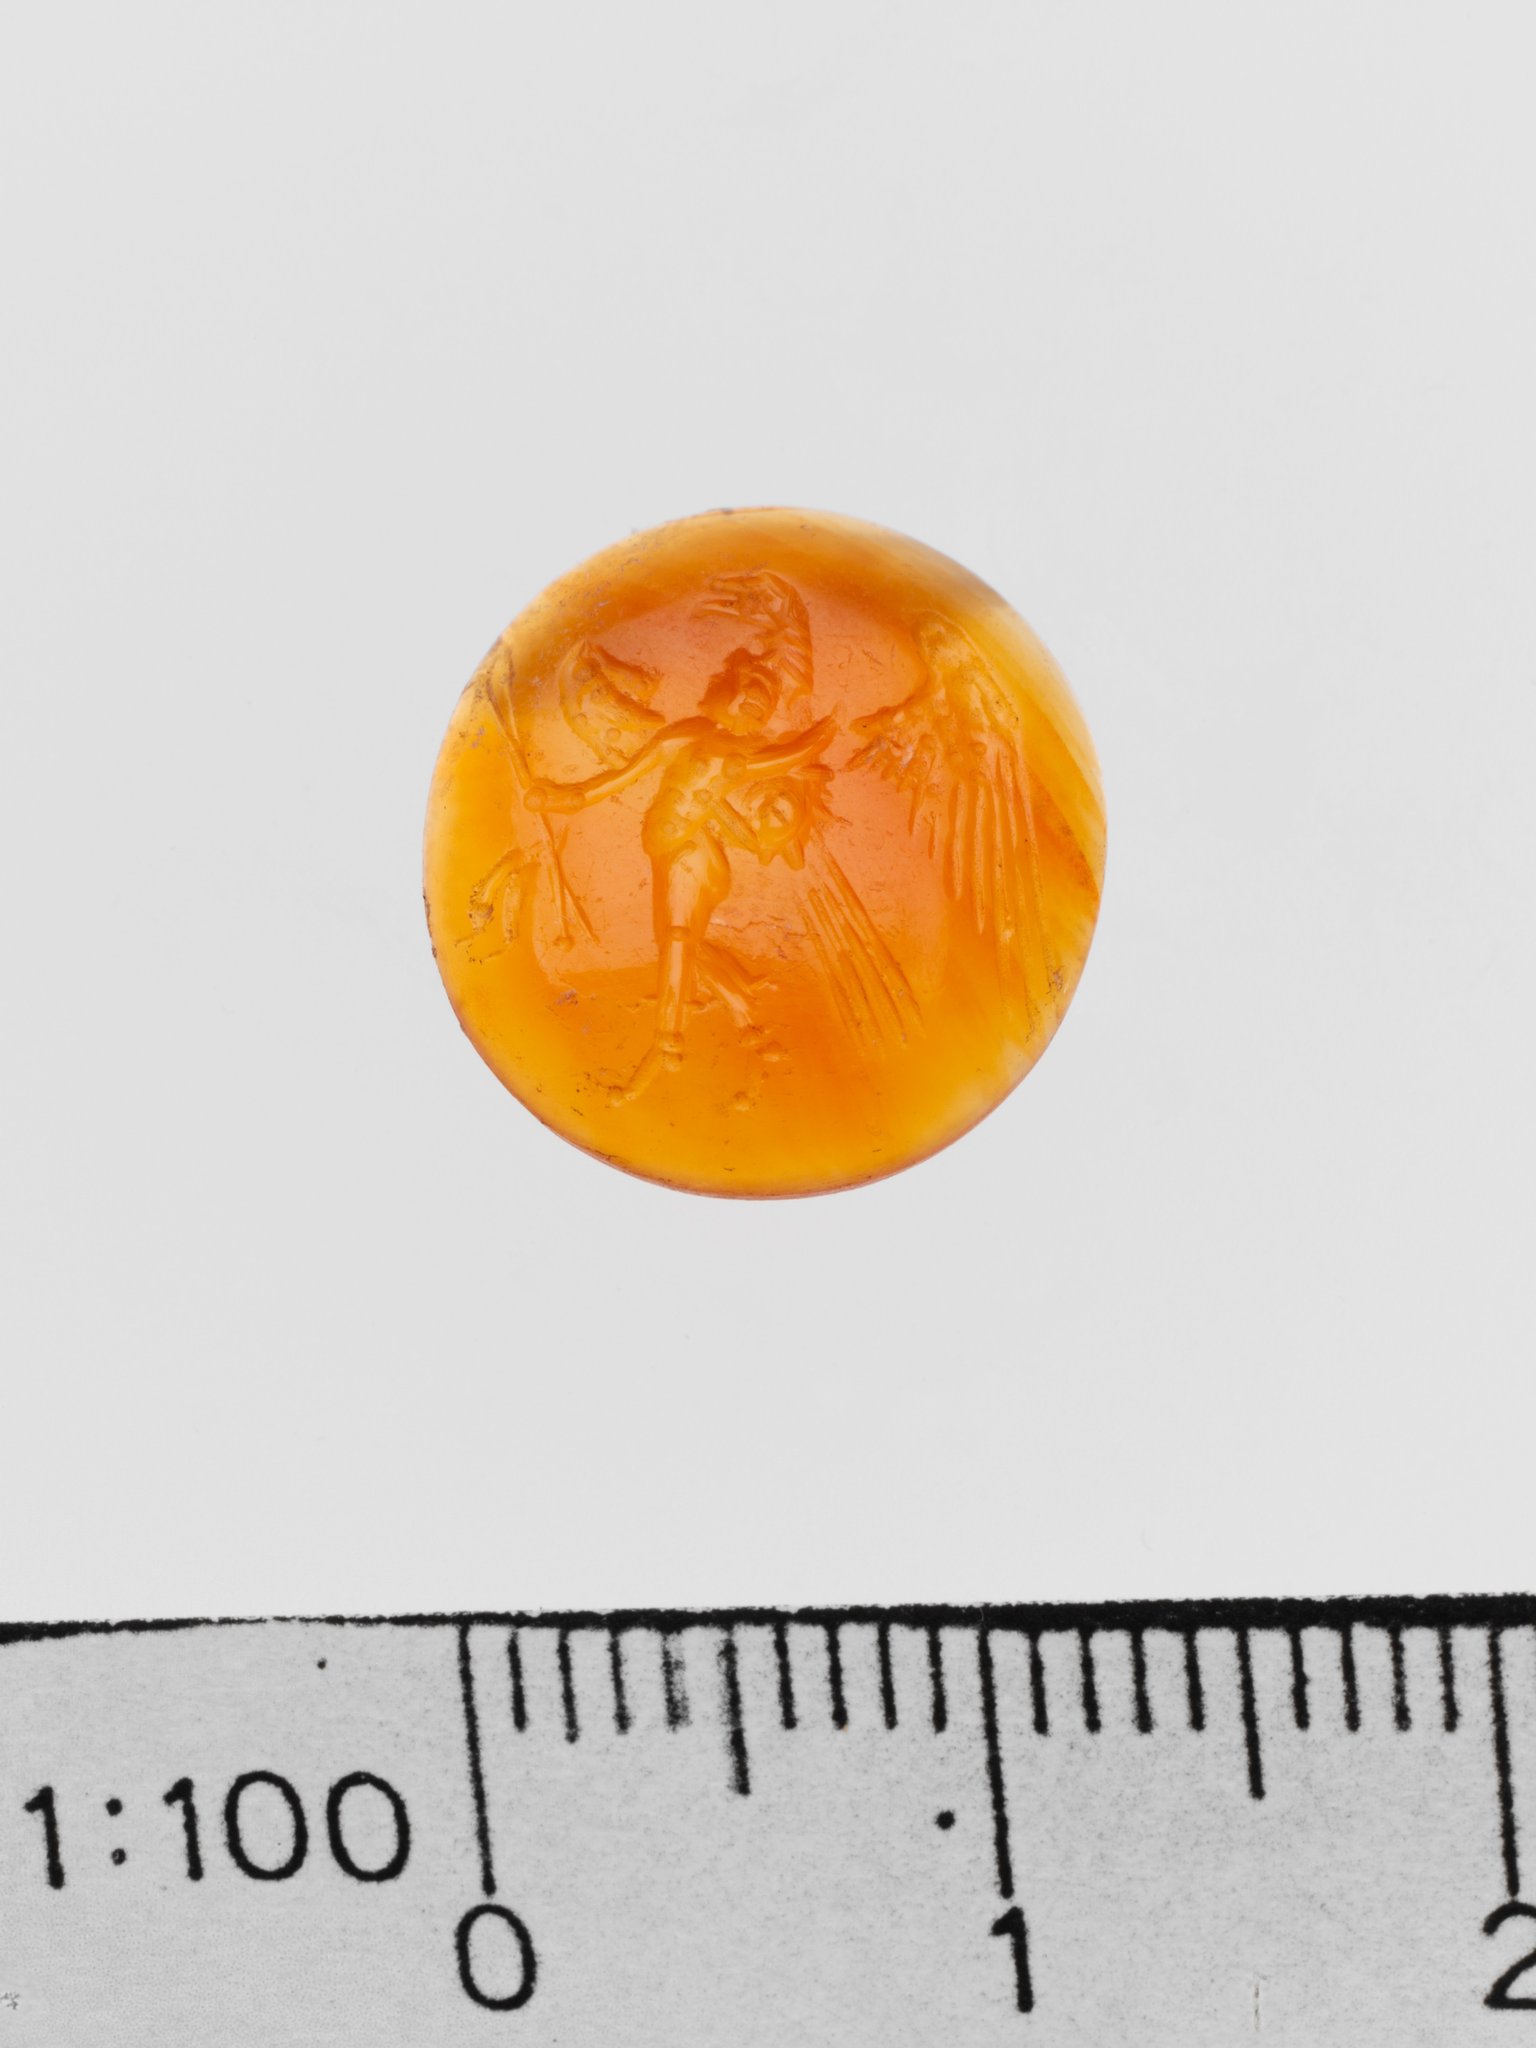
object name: intaglio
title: Sard ring stone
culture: roman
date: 1-100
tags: eagles,zeus